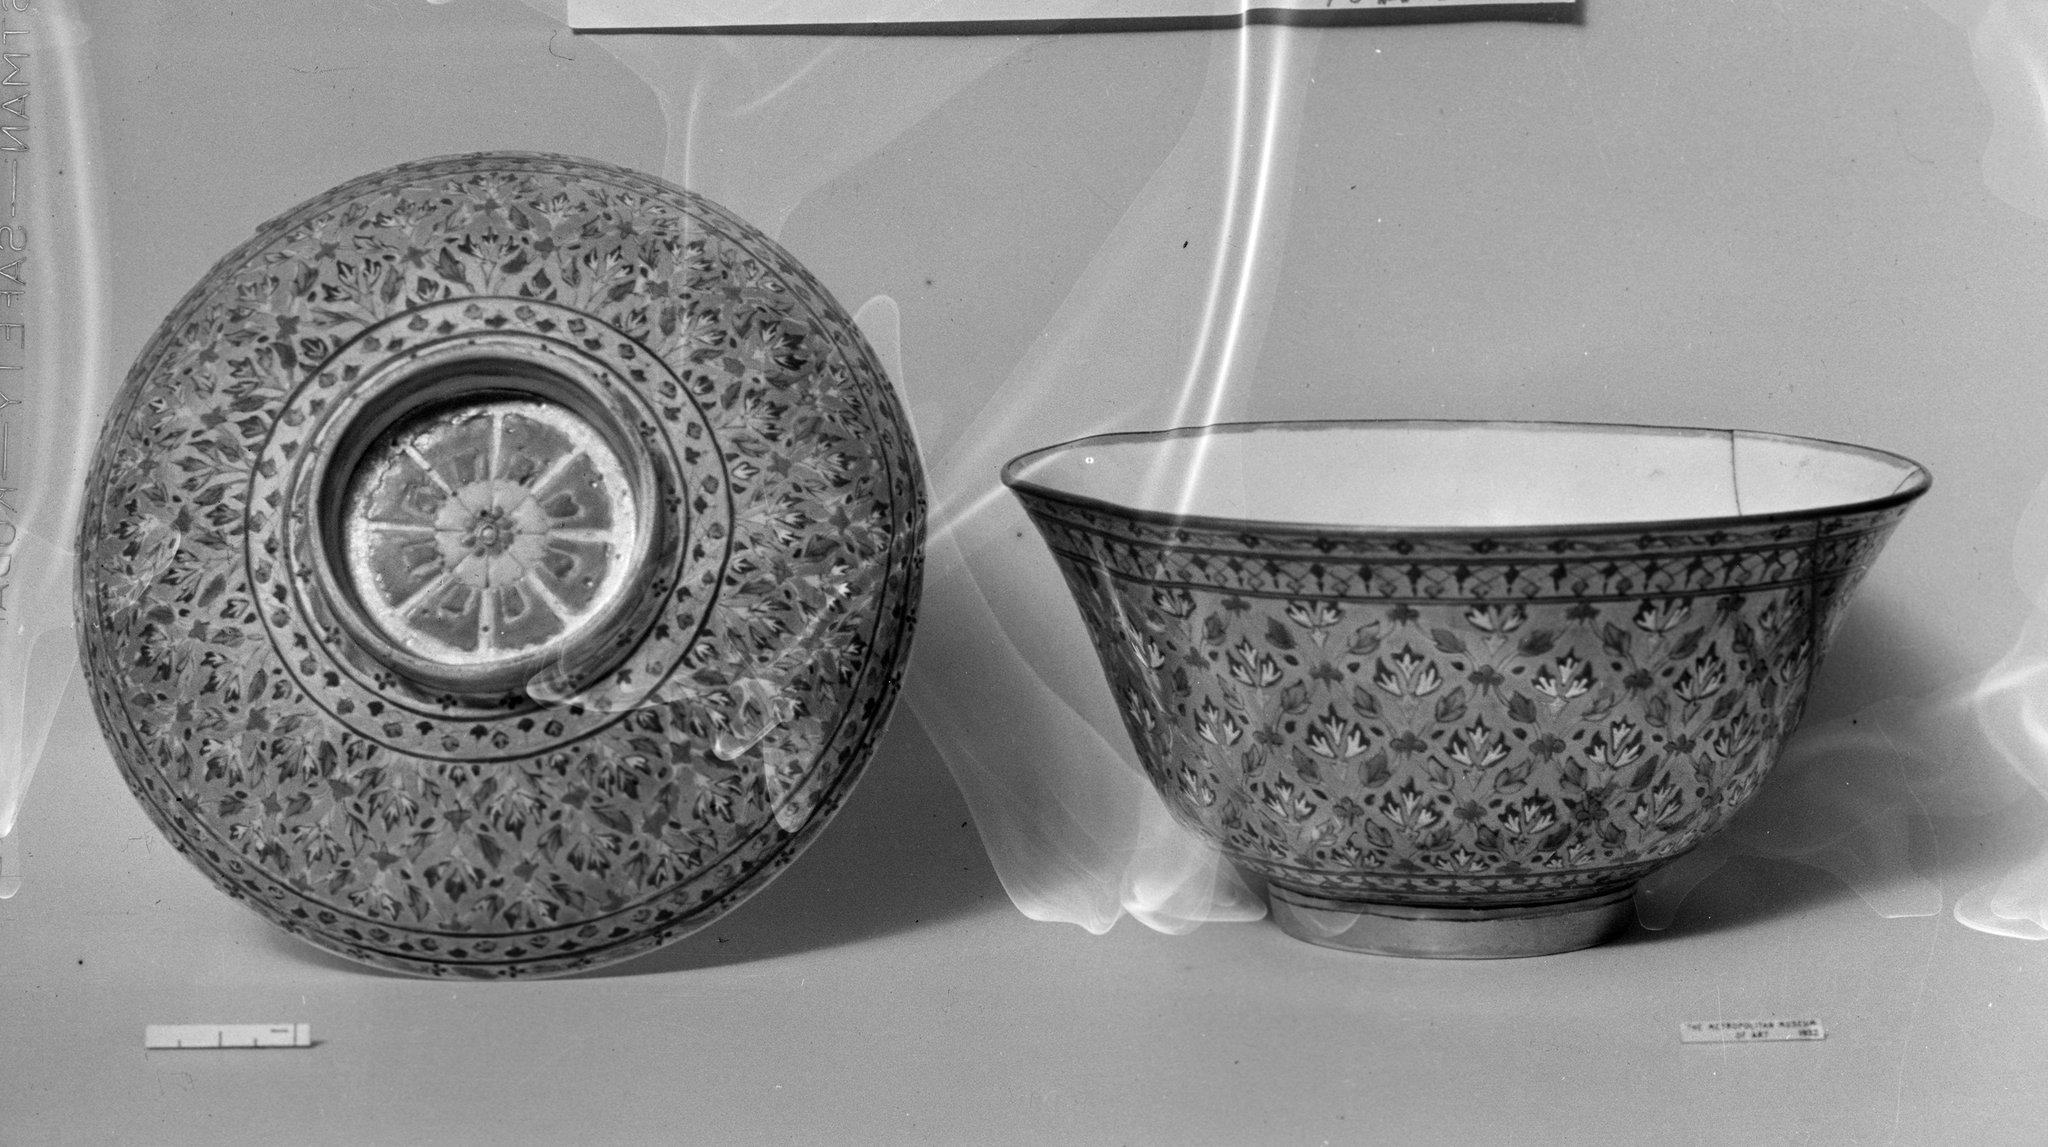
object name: covered bowl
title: Covered bowl with floral pattern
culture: chinese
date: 1801-1900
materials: enamel, porcelain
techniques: overglaze, painting, polychrome